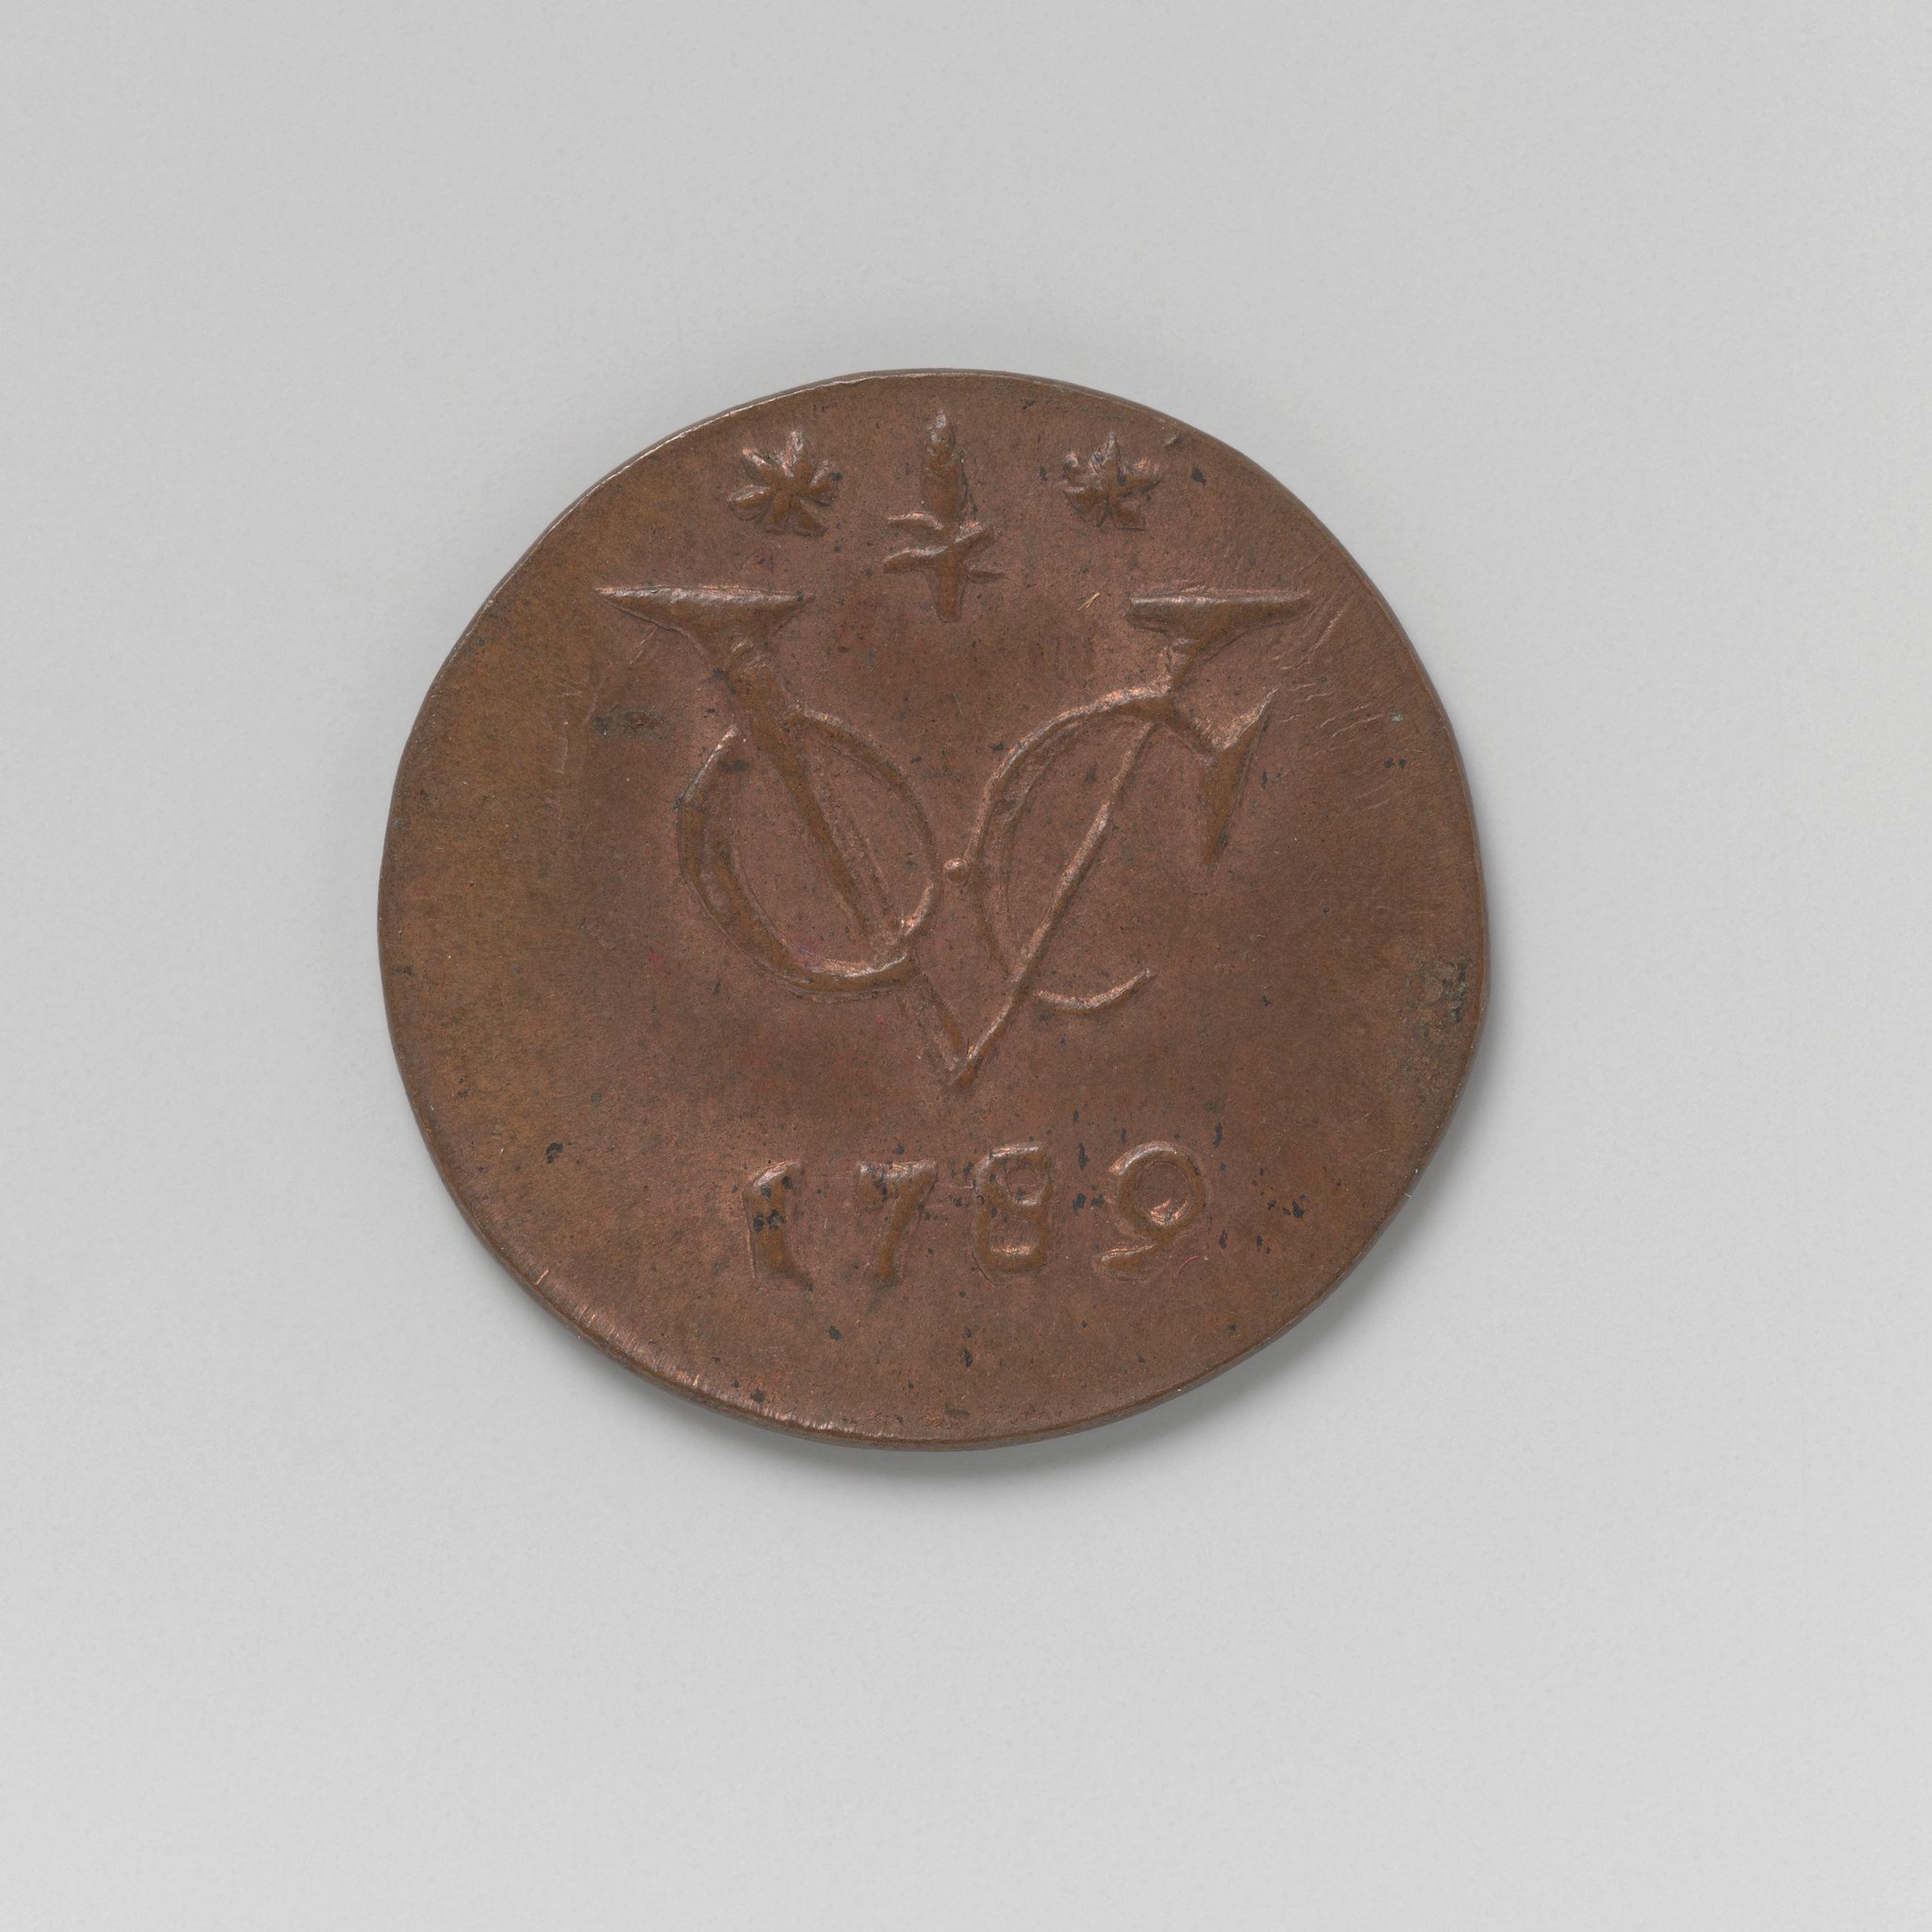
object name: coin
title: VOC, ½ duit Gelderland,1789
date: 1789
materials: copper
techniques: striking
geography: harderwijk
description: Koperen munt. Voorzijde: tussen wapenspreuk gekroond wapenschild van Gelderland. Keerzijde: monogram van de VOC, waarboven muntmeesterteken en waaronder jaartal. Gladde rand.